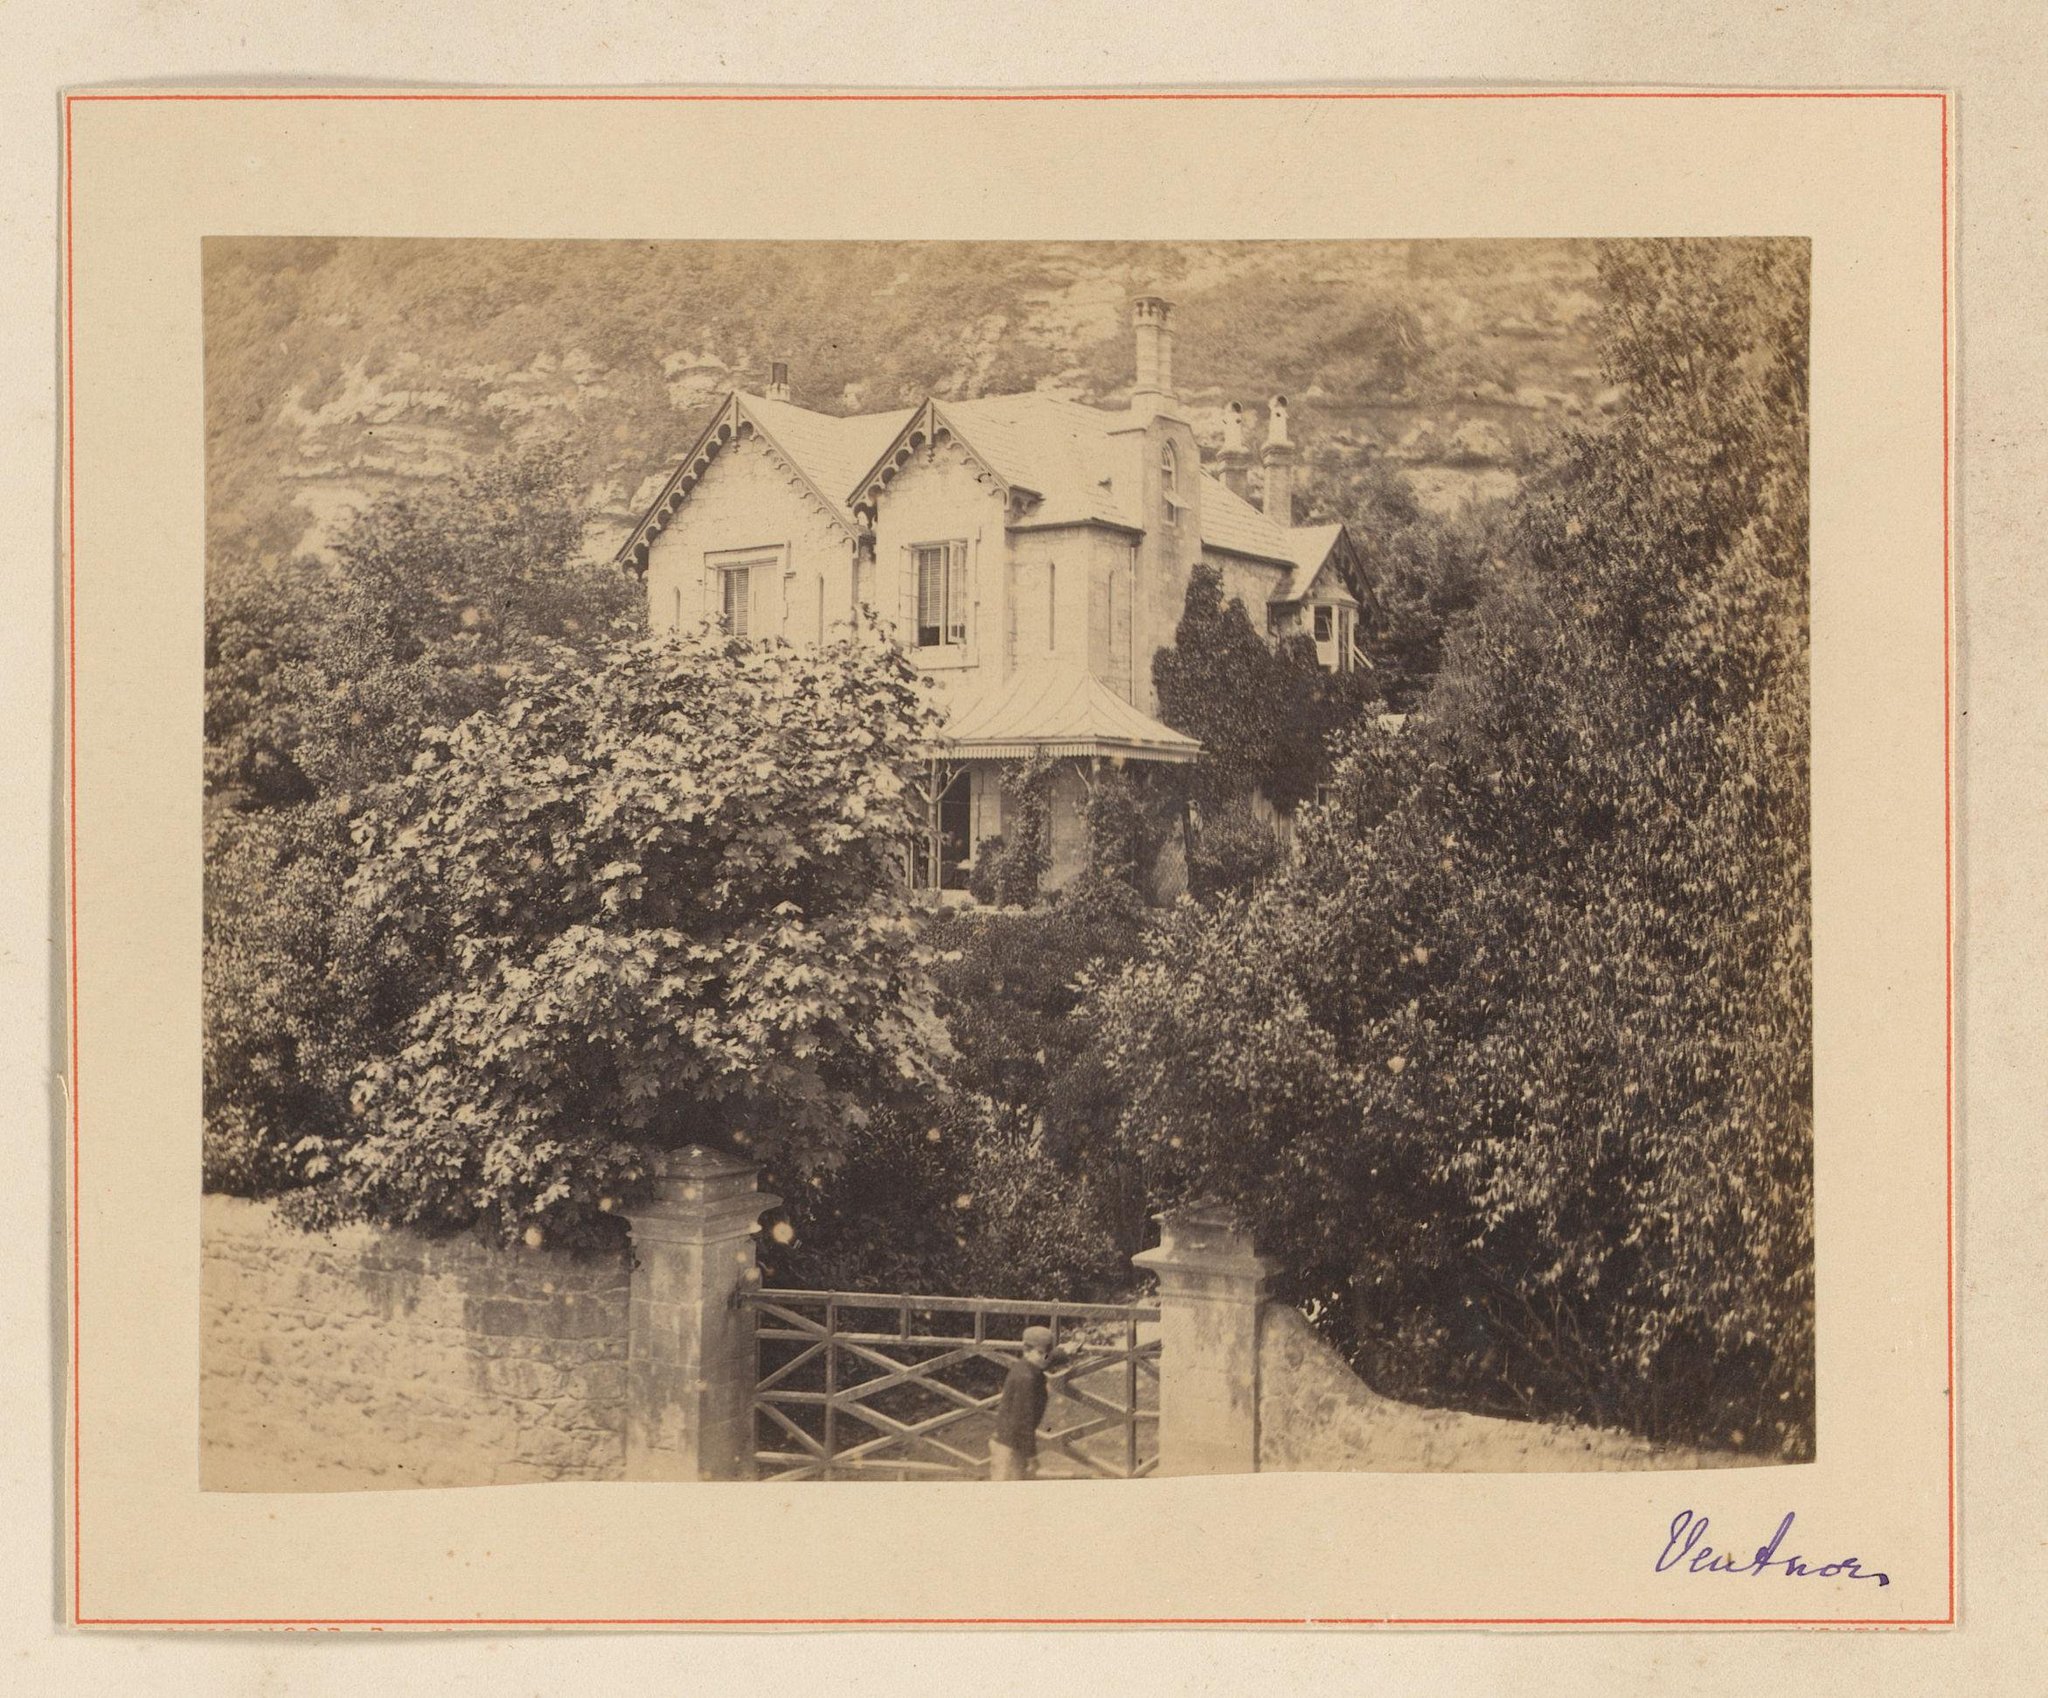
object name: photograph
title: Villa in Ventnor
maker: Anonymous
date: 1870-1890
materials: paper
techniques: albumen print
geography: ventnor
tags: villa